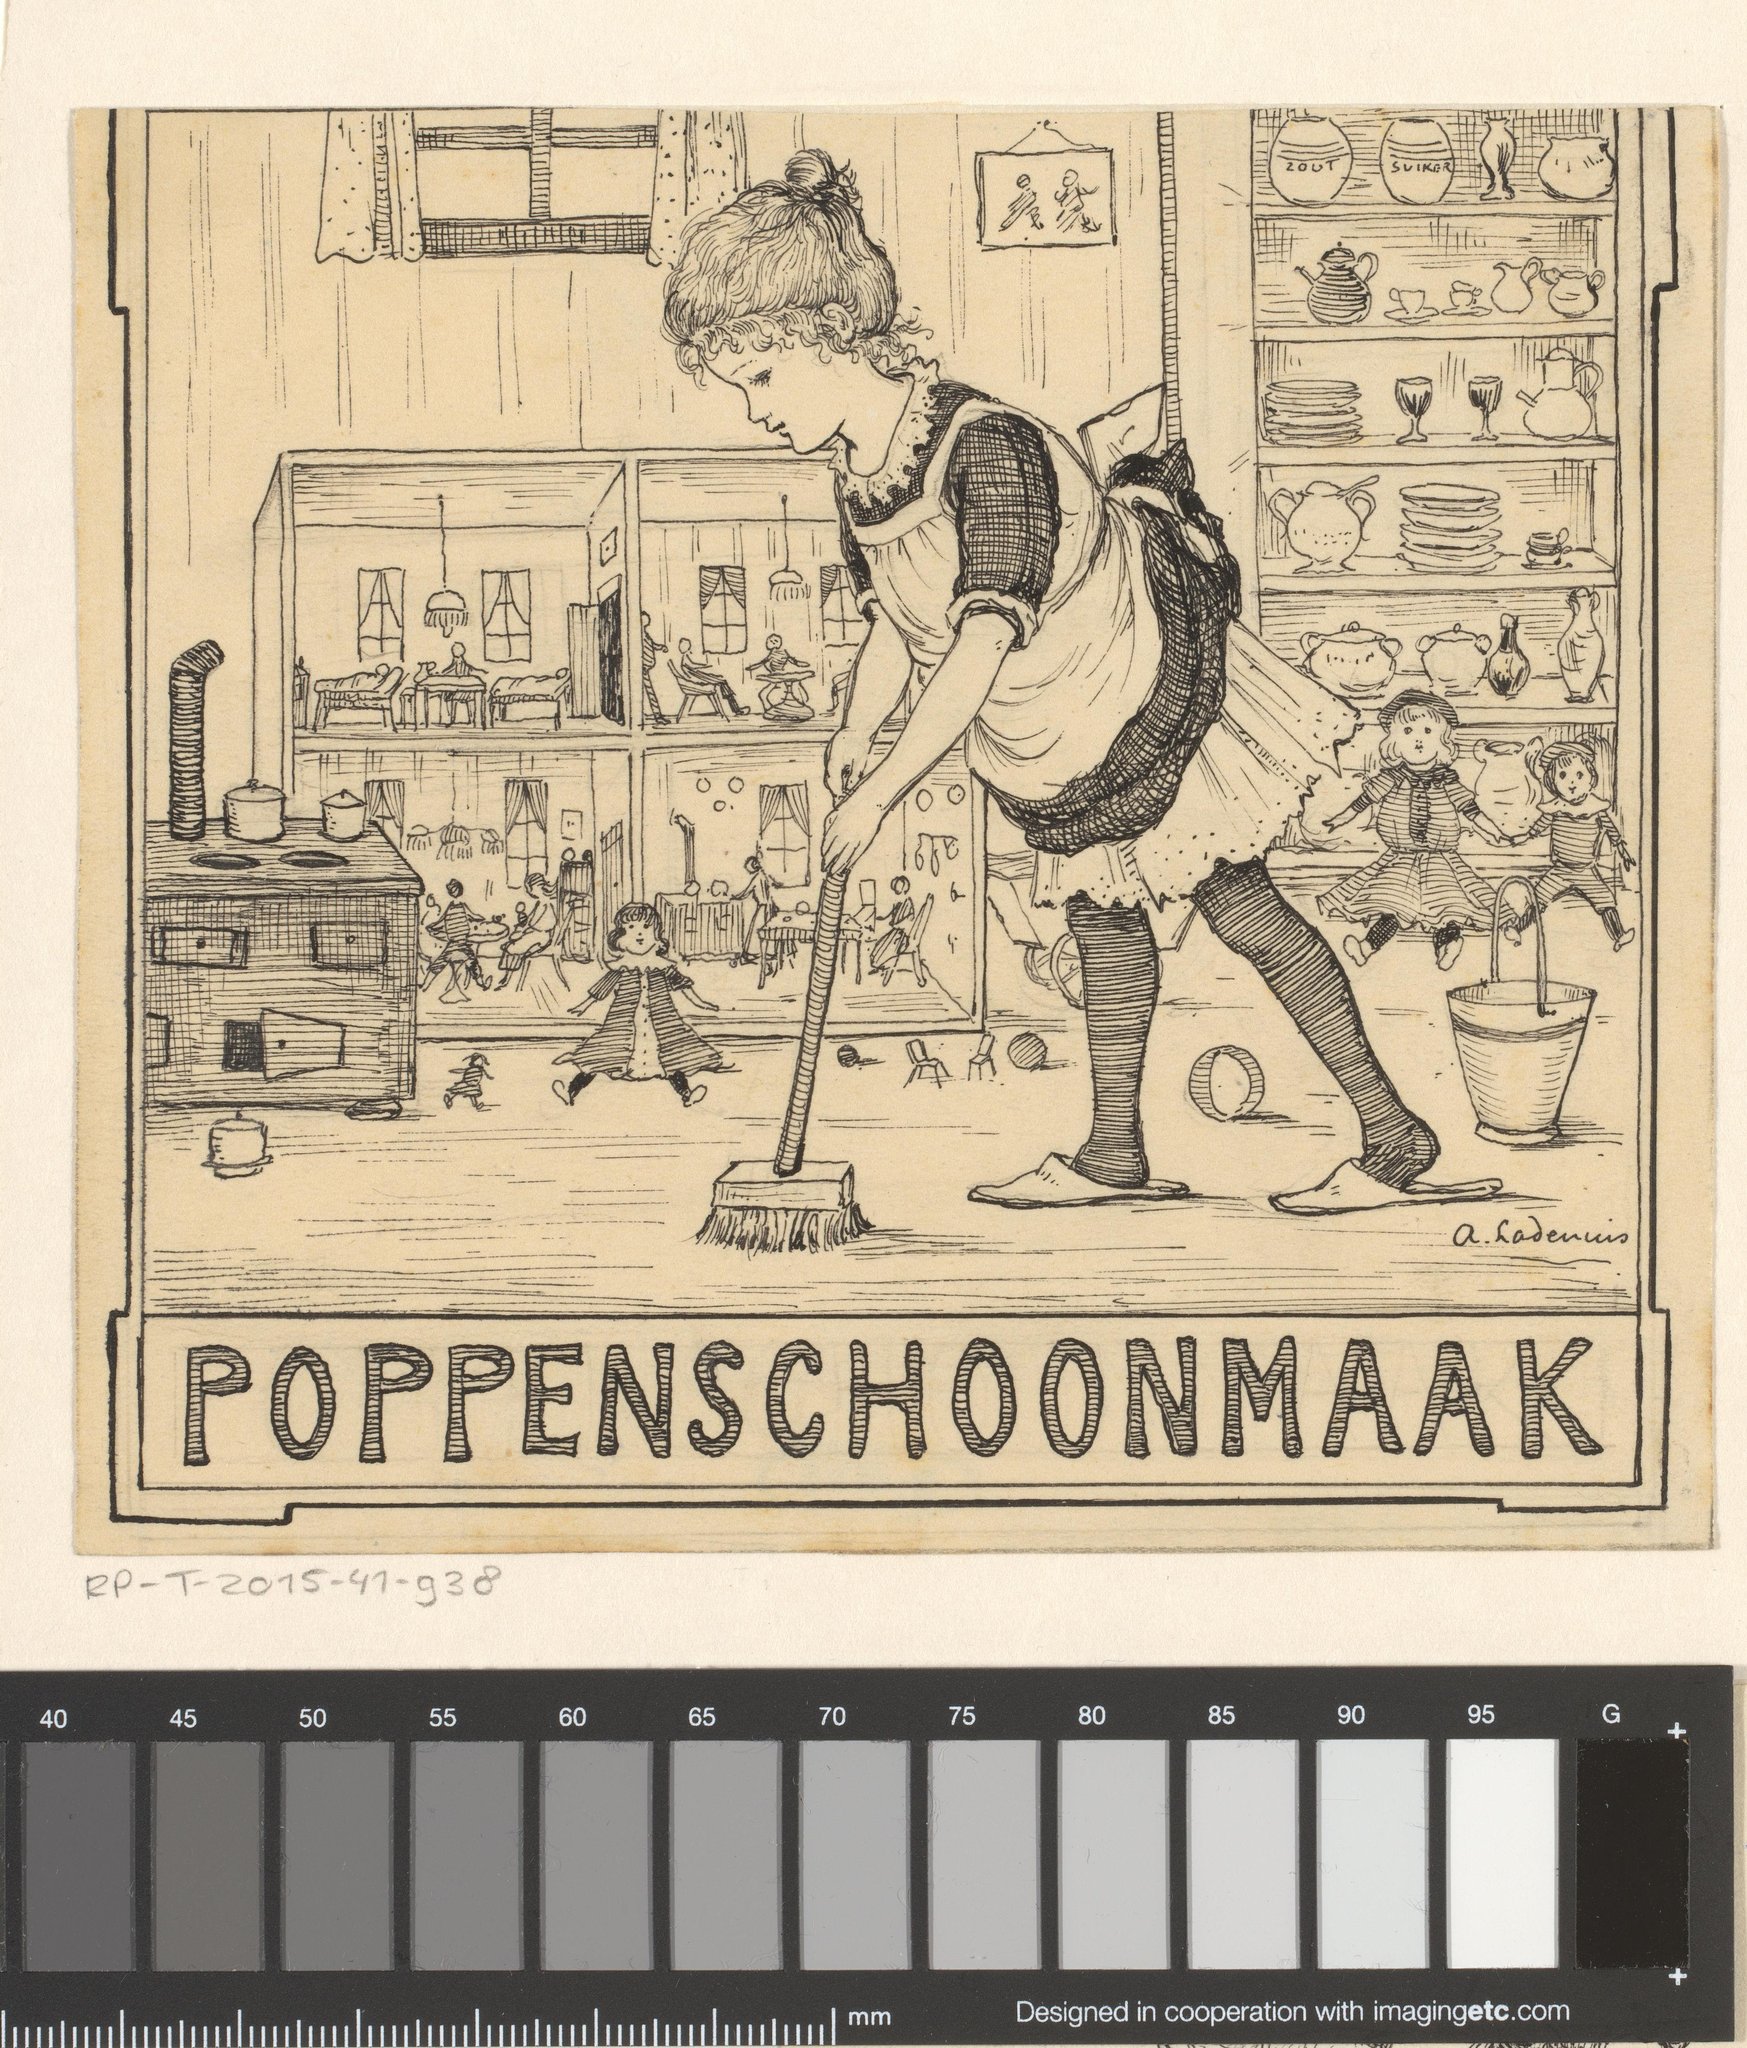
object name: drawing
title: Poppenschoonmaak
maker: adri ladenius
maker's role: draughtsman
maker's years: 1883-1953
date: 1893-1953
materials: ink, paper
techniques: pen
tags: (playing with) dolls, cleaning (the house)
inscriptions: collector's mark: Lugt 2228, annotation: ‘Poppenschoonmaak’, signature: ‘A. Ladenius’, :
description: Een meisje met een schort voor haar jurk bezemt de vloer rond een poppenhuis. Op de grond staan poppen en kleine meubels. Op de achtergrond een servieskast.